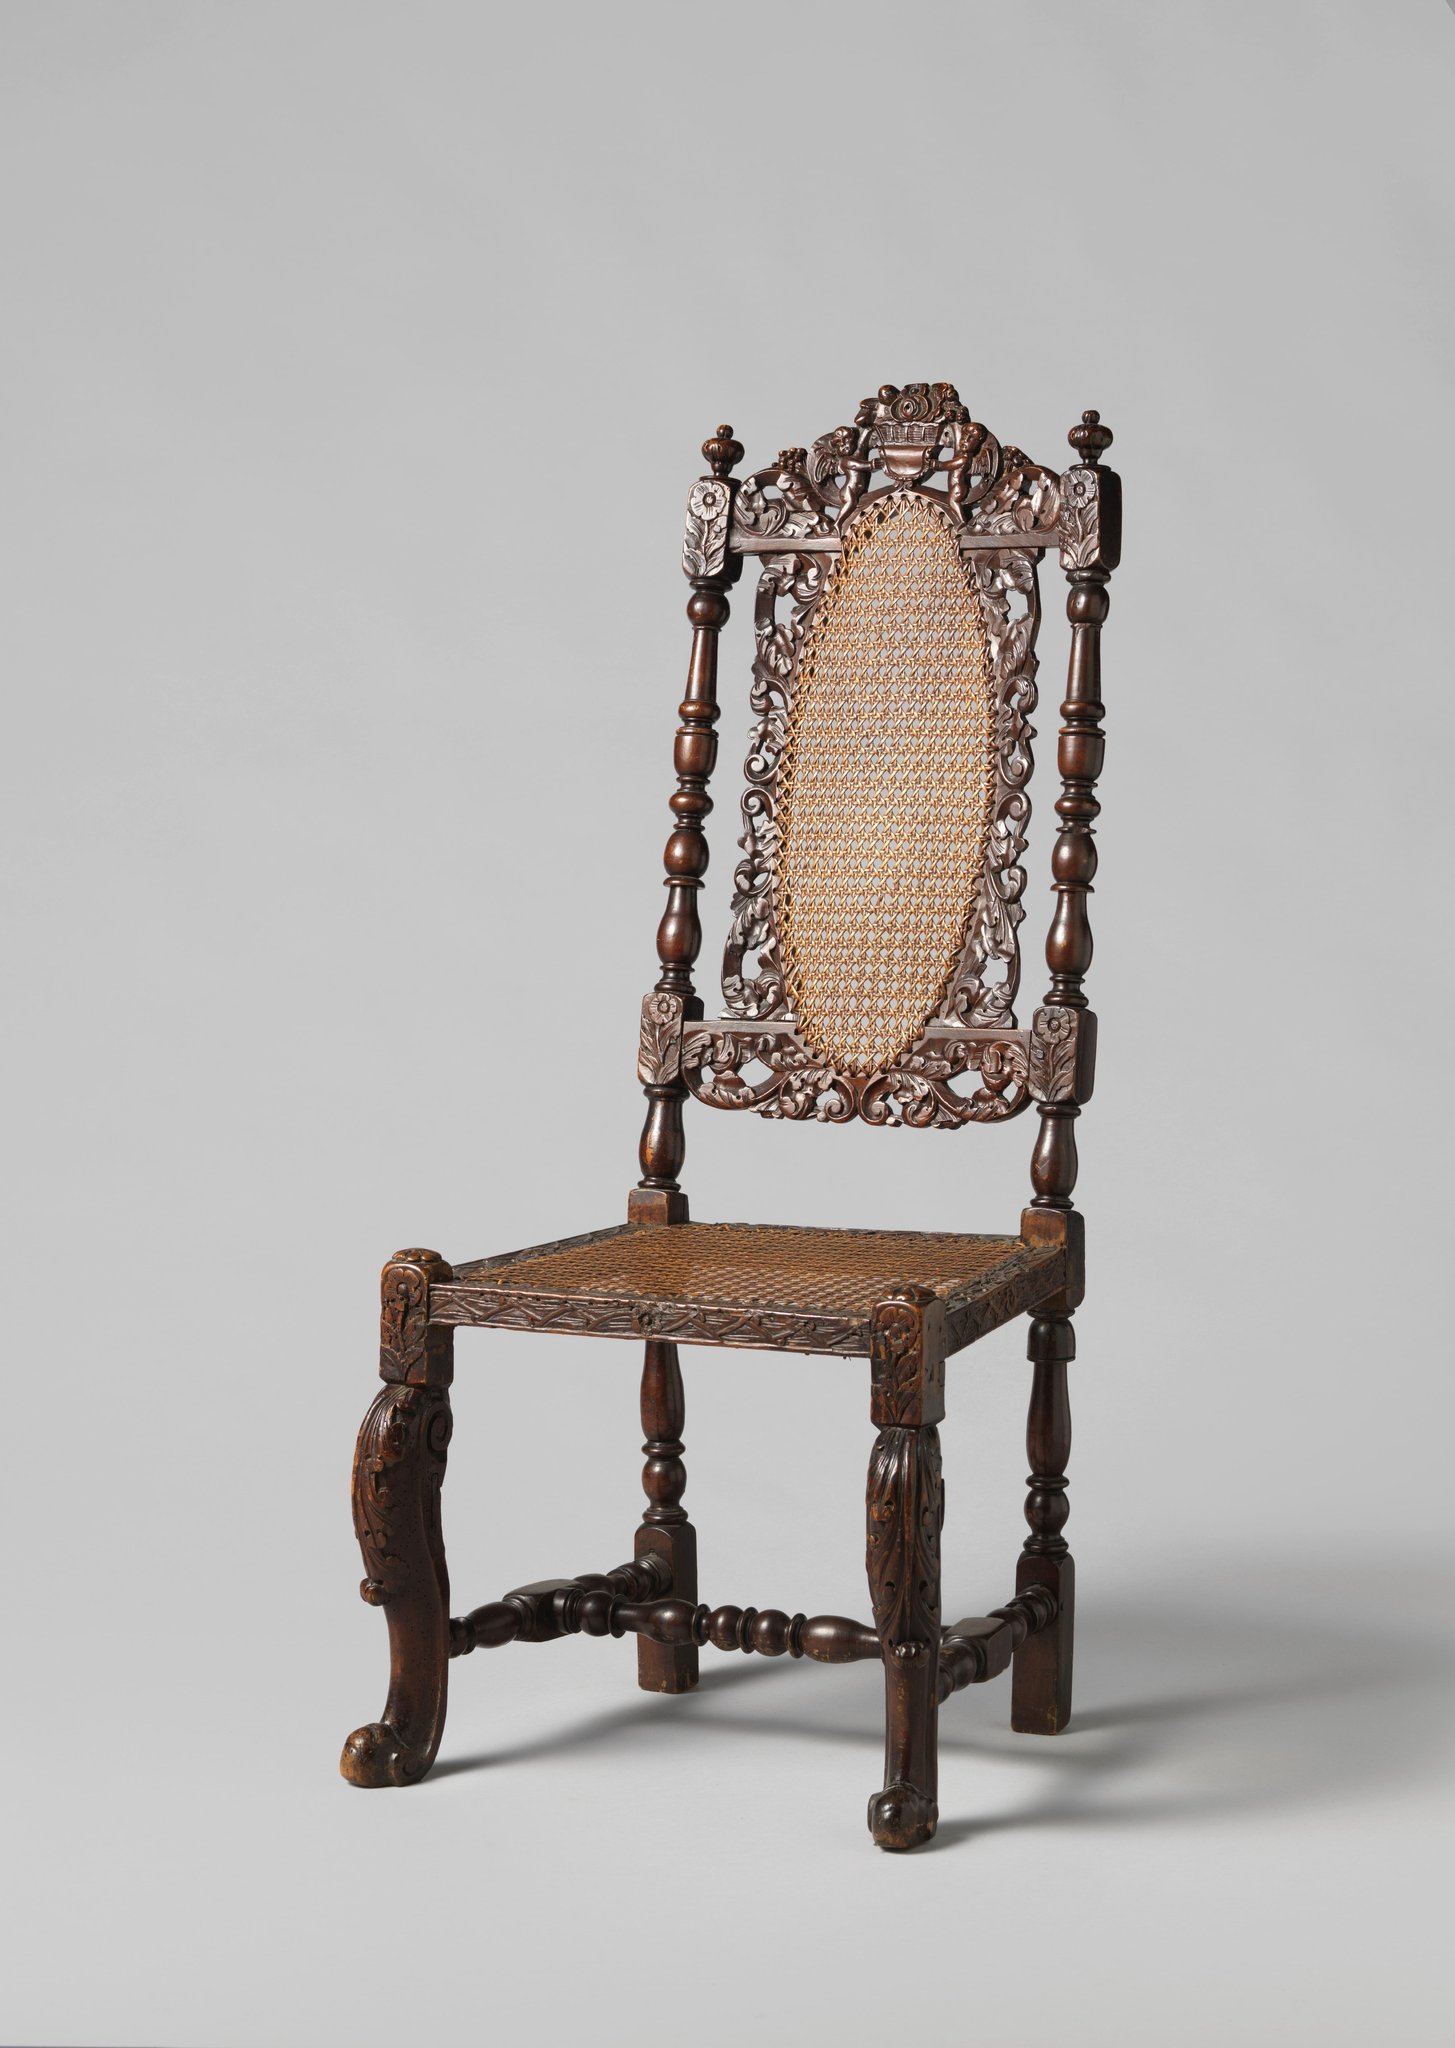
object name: chair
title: Stoel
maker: Anonymous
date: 1700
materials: wood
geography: northern netherlands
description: Stoel van notenhout. Het meubel is met riet bespannen en rust op S-vormige voorpoten en gelede achterpoten, die door een H-vormig geleed kruis verbonden zijn. De voorpoten dragen bovenaan gestoken acanthusblad. De zitregels zijn aan de bovenzijde en aan de voorkant en zijkanten met steekwerk versierd. De vrijstaande rugstijlen vertonen geledingen en worden door vaasjes bekroond. De bovendorpel heeft in het midden twee putti, die een bloemkorf dragen. De huizen hebben aan de voorzijde bloemmotieven.